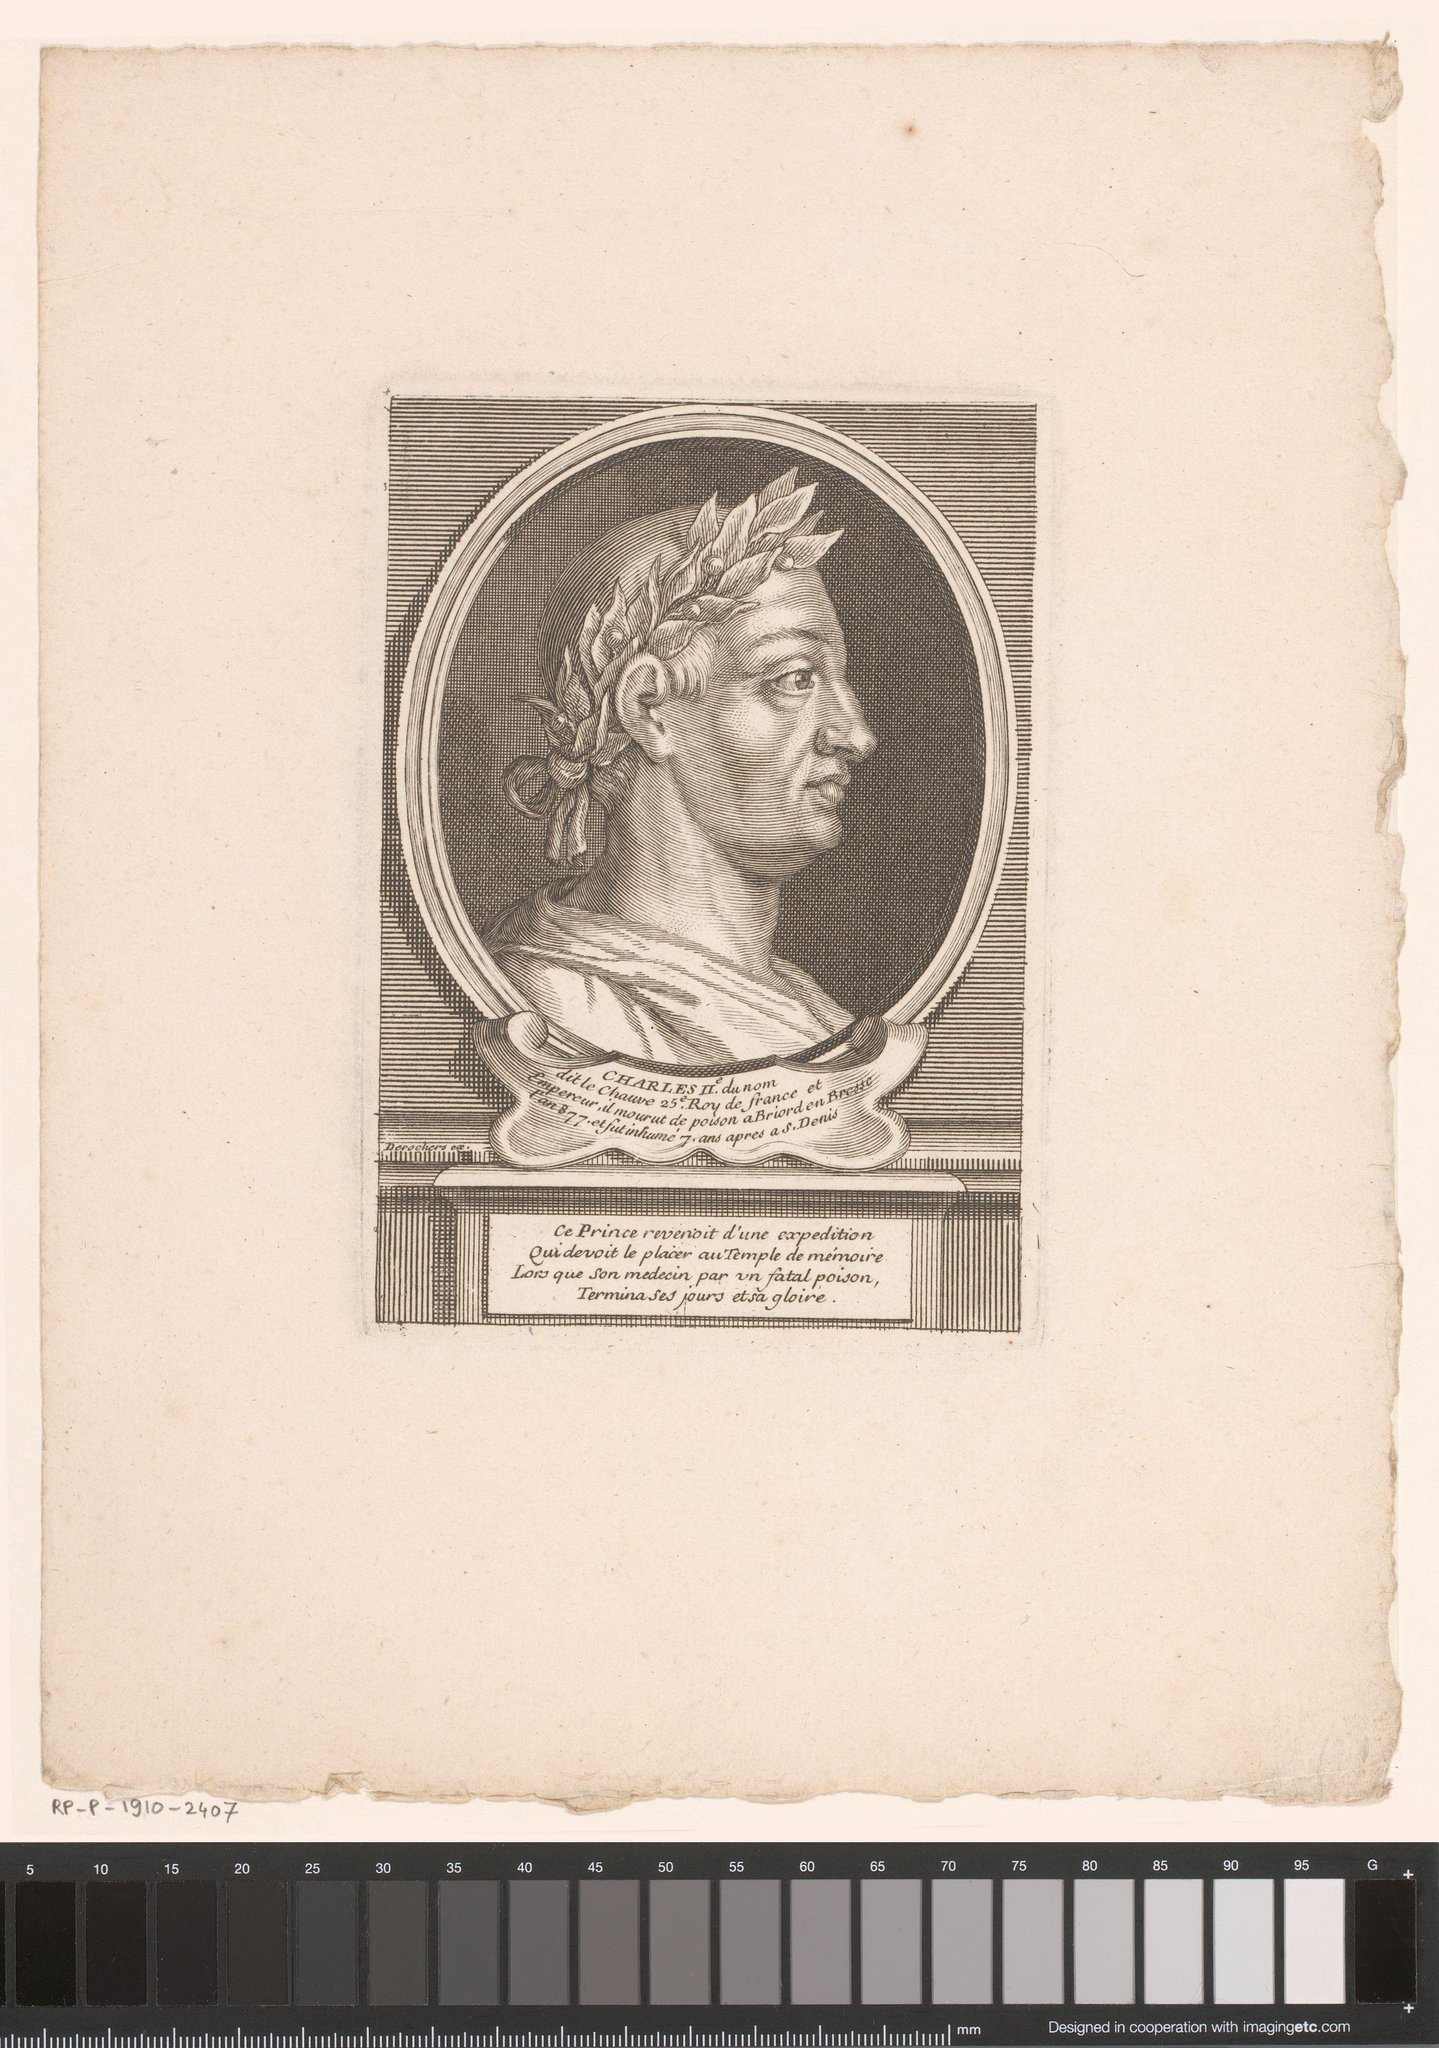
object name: print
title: Verzameling portretten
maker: étienne desrochers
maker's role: print maker, publisher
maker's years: 1668-1741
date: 1726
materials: paper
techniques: engraving, etching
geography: paris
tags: historical persons, king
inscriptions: collector's mark: Lugt 2228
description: Behoort waarschijnlijk tot een serie portretten, grotendeels door Etienne Desrochers, getiteld: 'Recueil de portraits de personnes qui se sont distinguées tant dans les Armes que dans Belles-Lettres et les Arts, comme aussi la famille royale de France et autres cours étrangères'. De serie werd initieel uitgegeven door Desrochers en aangekondigd in 'Mercure' in mei 1726, p. 985. Echter was Desrochers reeds enkele jaren eerder begonnen met het uitgeven van de serie. Na de dood van Desrochers werd de serie voortgezet door Gilles Edme Petit. Een latere staat werd uitgegeven door Jean François Daumont in Parijs.